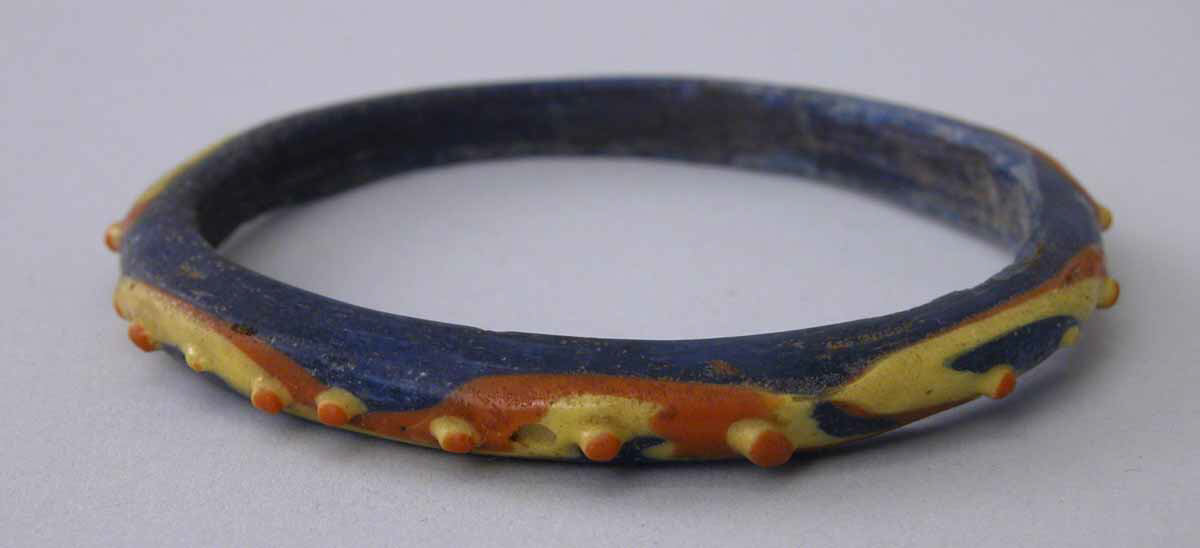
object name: bracelet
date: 1301-1500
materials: glass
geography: egypt or syria